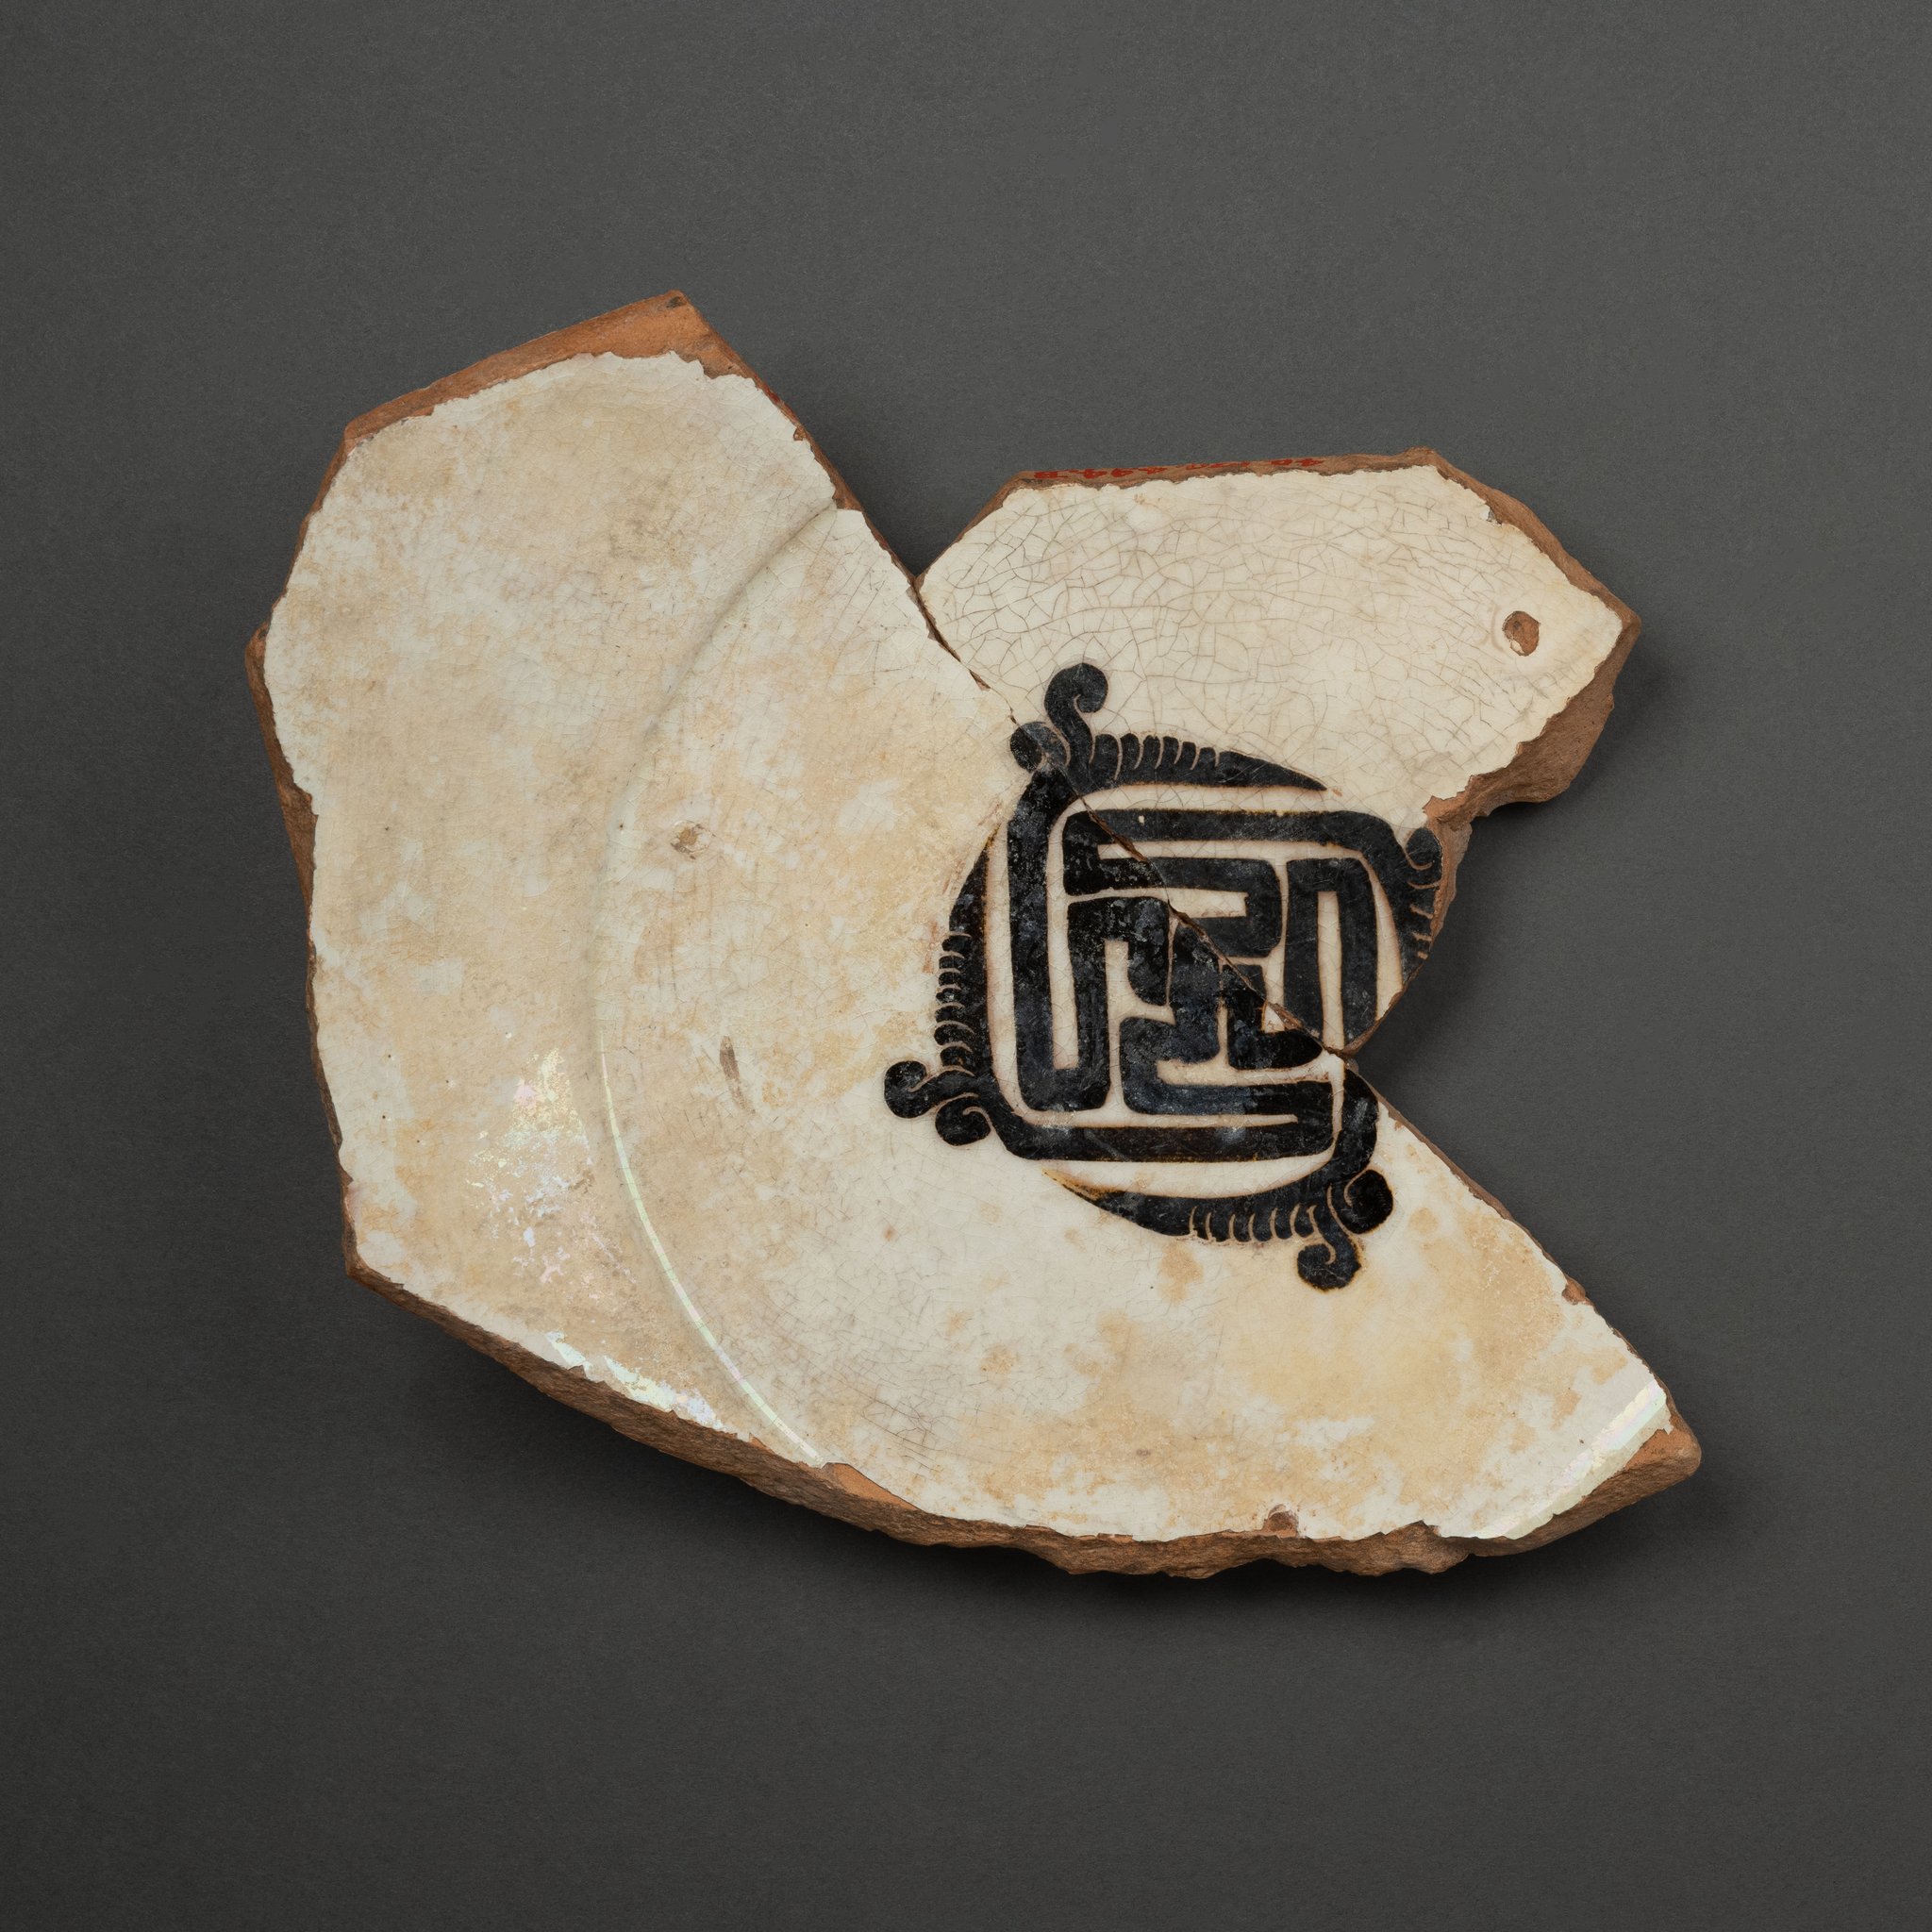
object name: fragment of a bowl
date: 801-1000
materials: earthenware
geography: iran